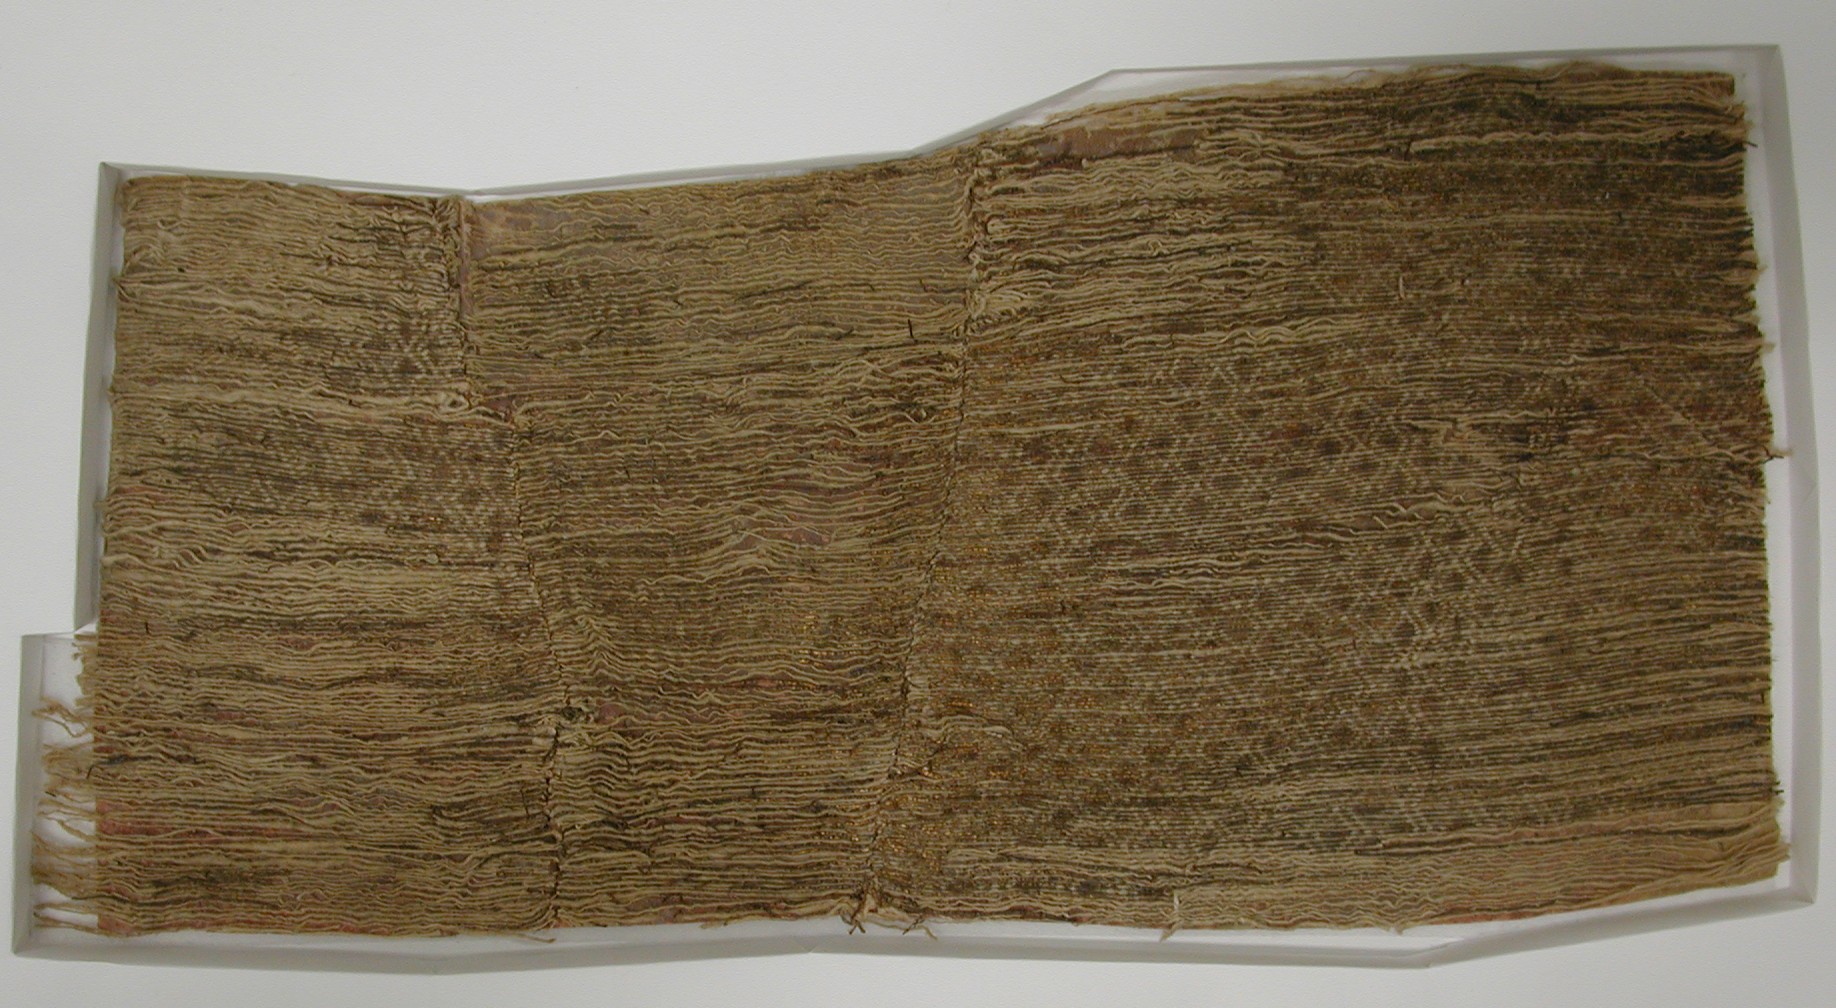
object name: piece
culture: central asian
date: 1001-1100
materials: cotton, metal thread